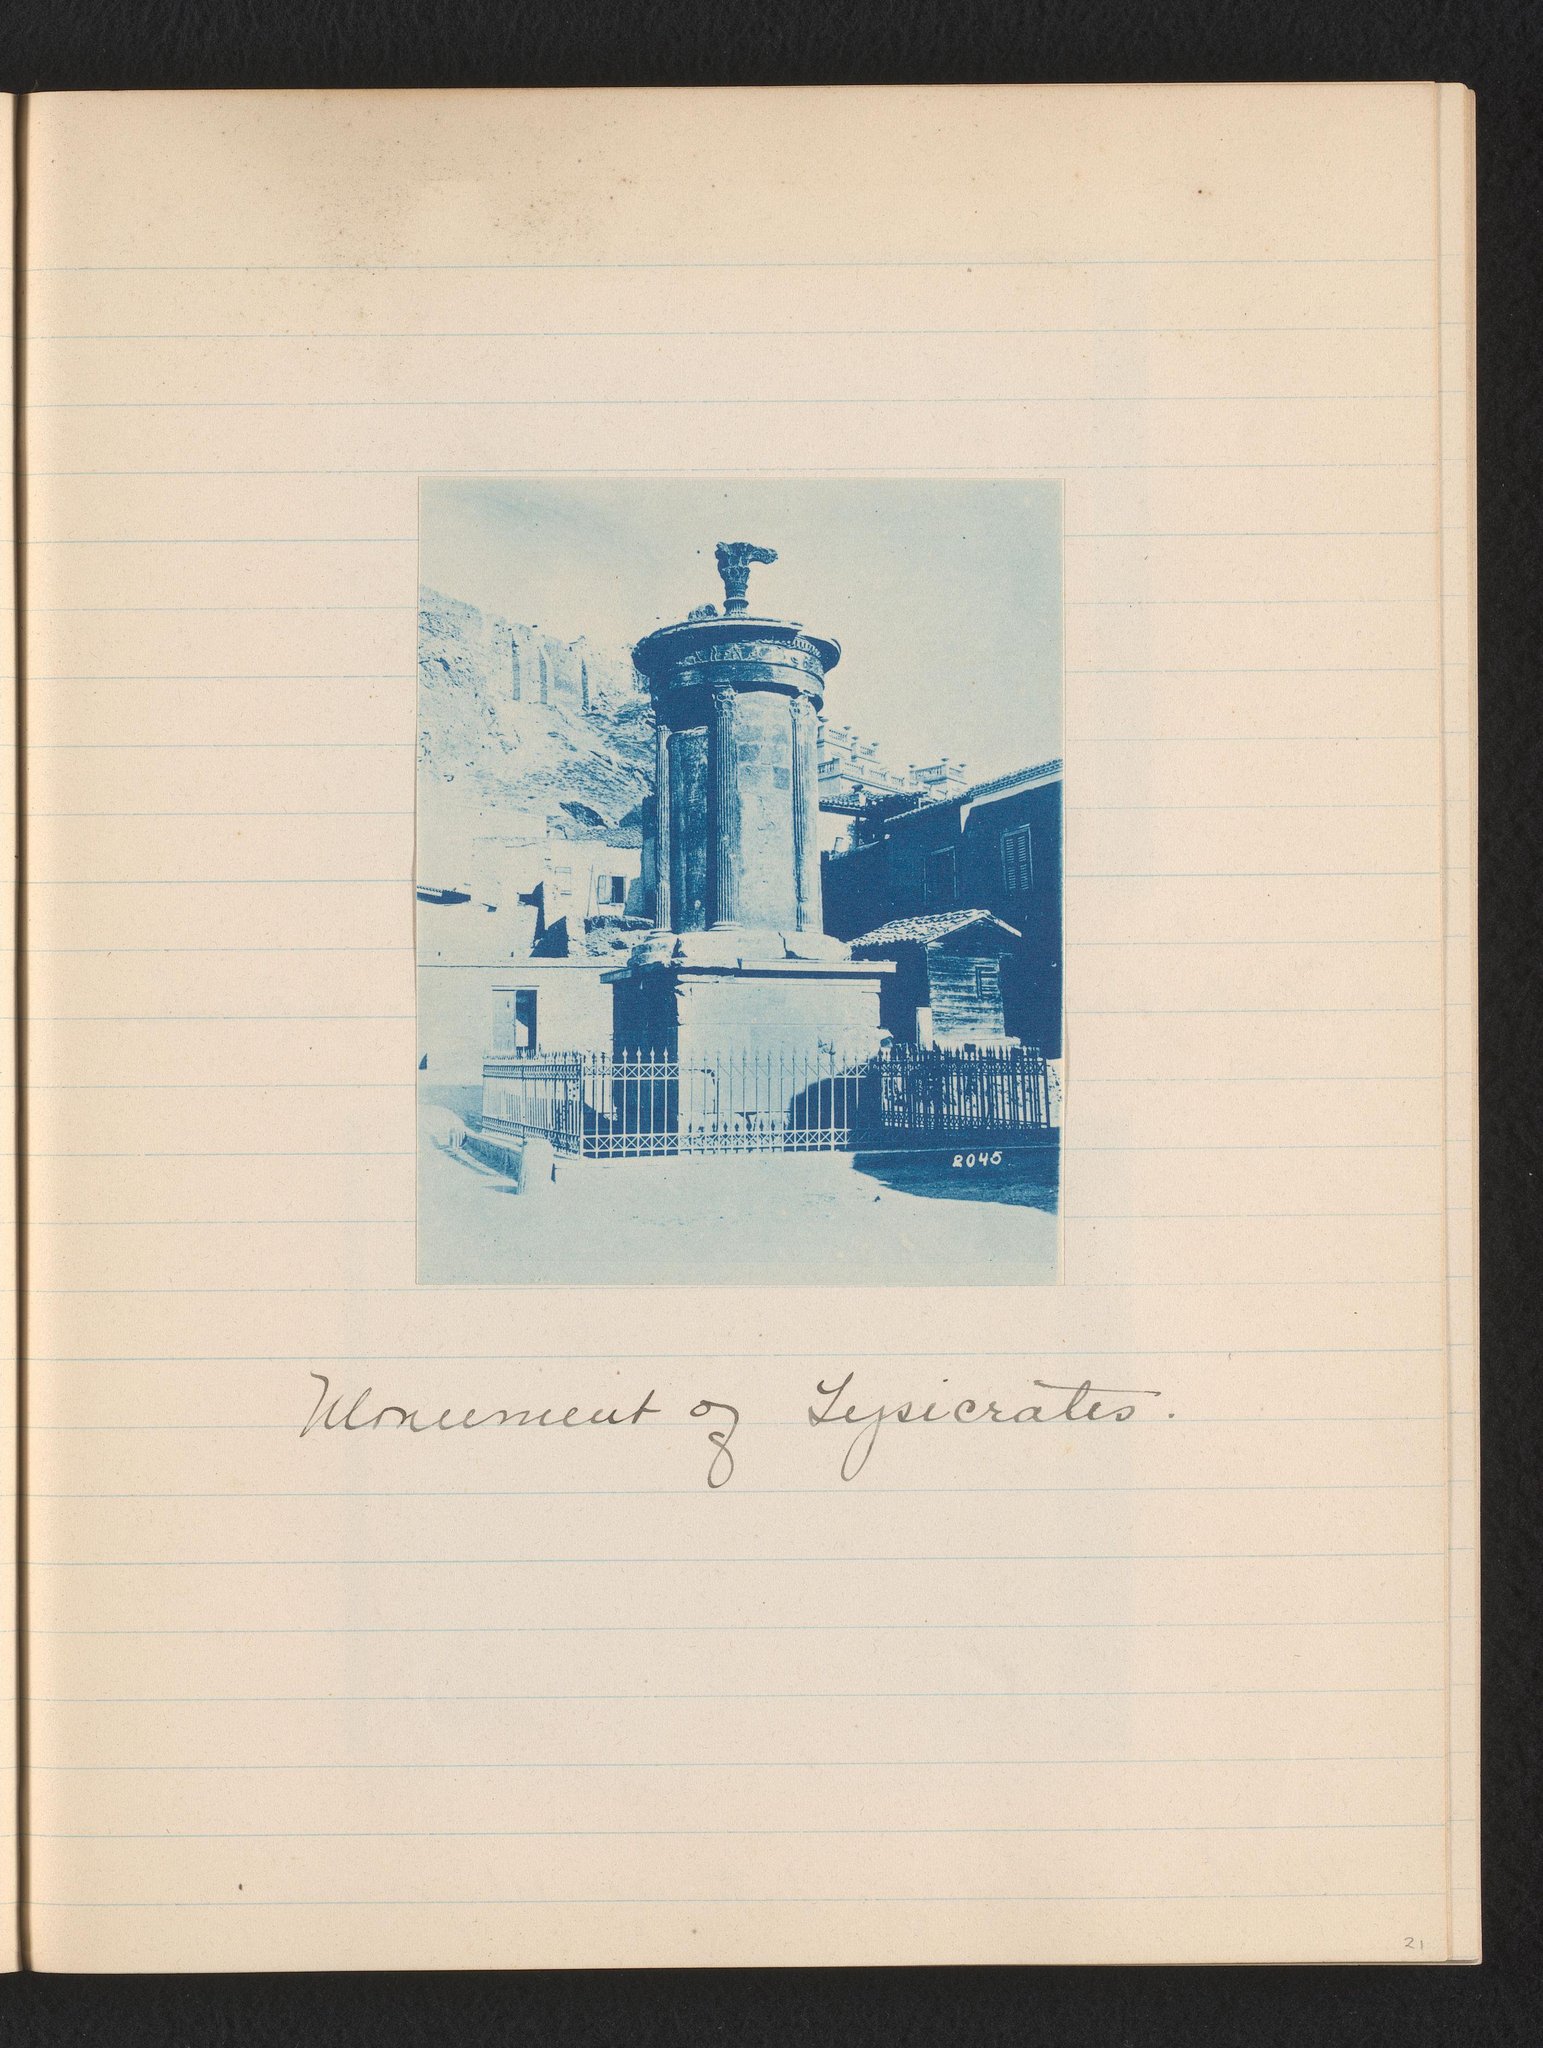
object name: album leaf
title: Monument van Lysicrates, Athene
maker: Anonymous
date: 1901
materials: paper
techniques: cyanotype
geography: athens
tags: monument, statue